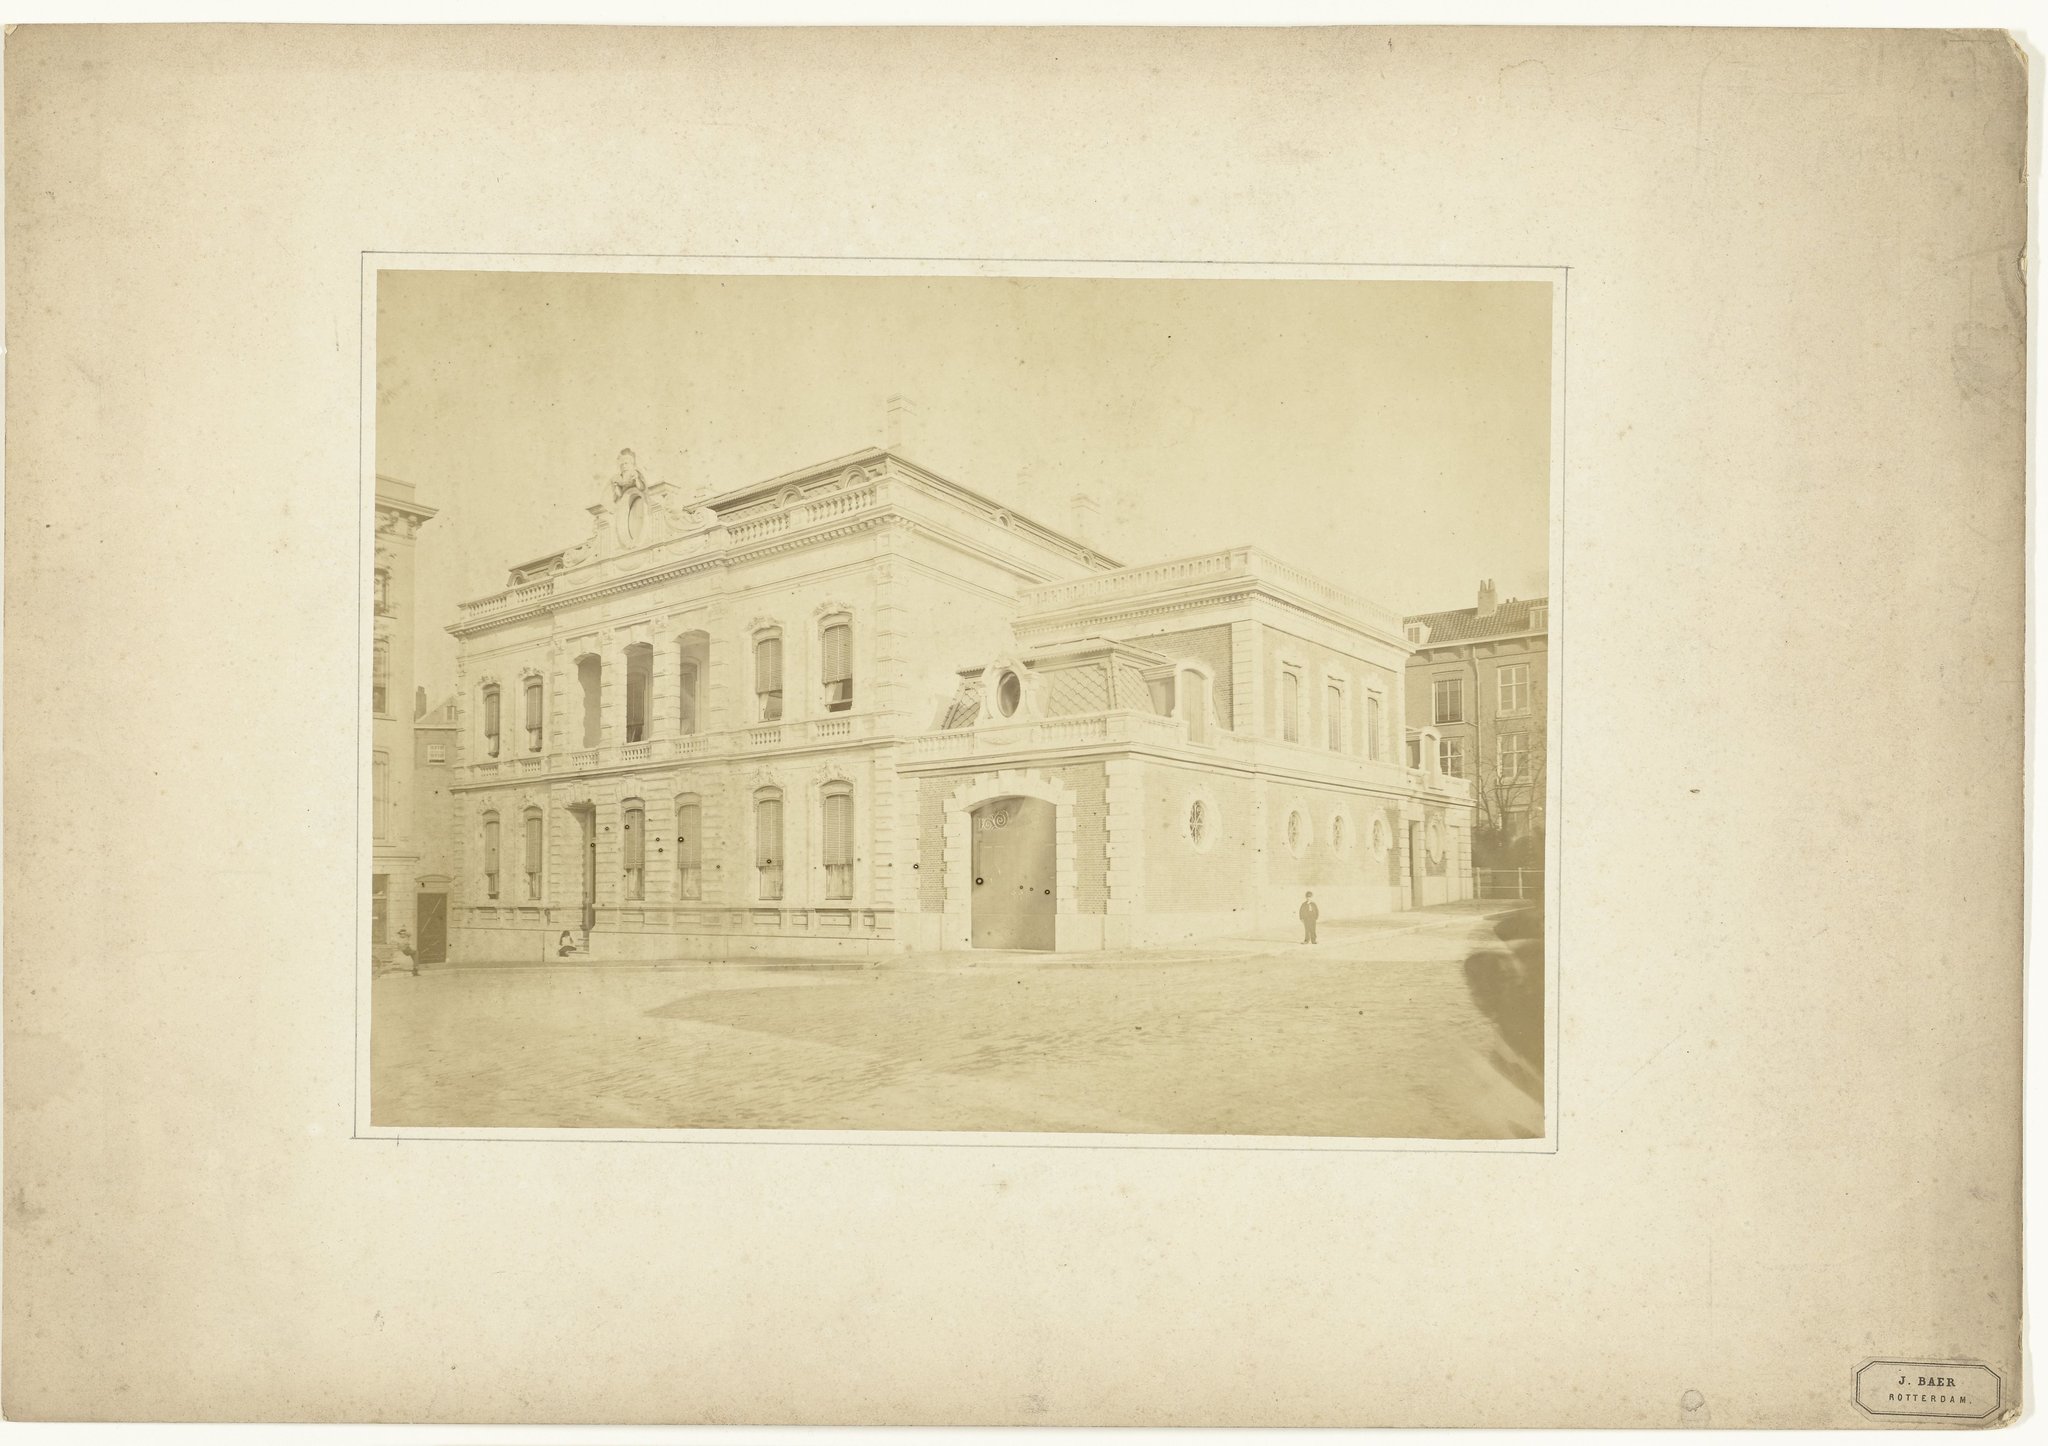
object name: photograph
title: Foto van neo-classicistisch (bekend?) gebouw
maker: johannes baer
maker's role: fotograaf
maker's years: 1840-1912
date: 1860-1890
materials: cardboard, paper, photographic support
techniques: albumen print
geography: rotterdam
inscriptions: label: ‘J.Baer//Rotterdam’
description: Foto van licht, neo-classicistisch gebouw aan een plein, van rechts vóór gefotografeerd zodat ook de zijkant van het gebouw erop staat. Een kind zit in de deuropening, een man in het zwart staat aan rechter zijkant gebouw.